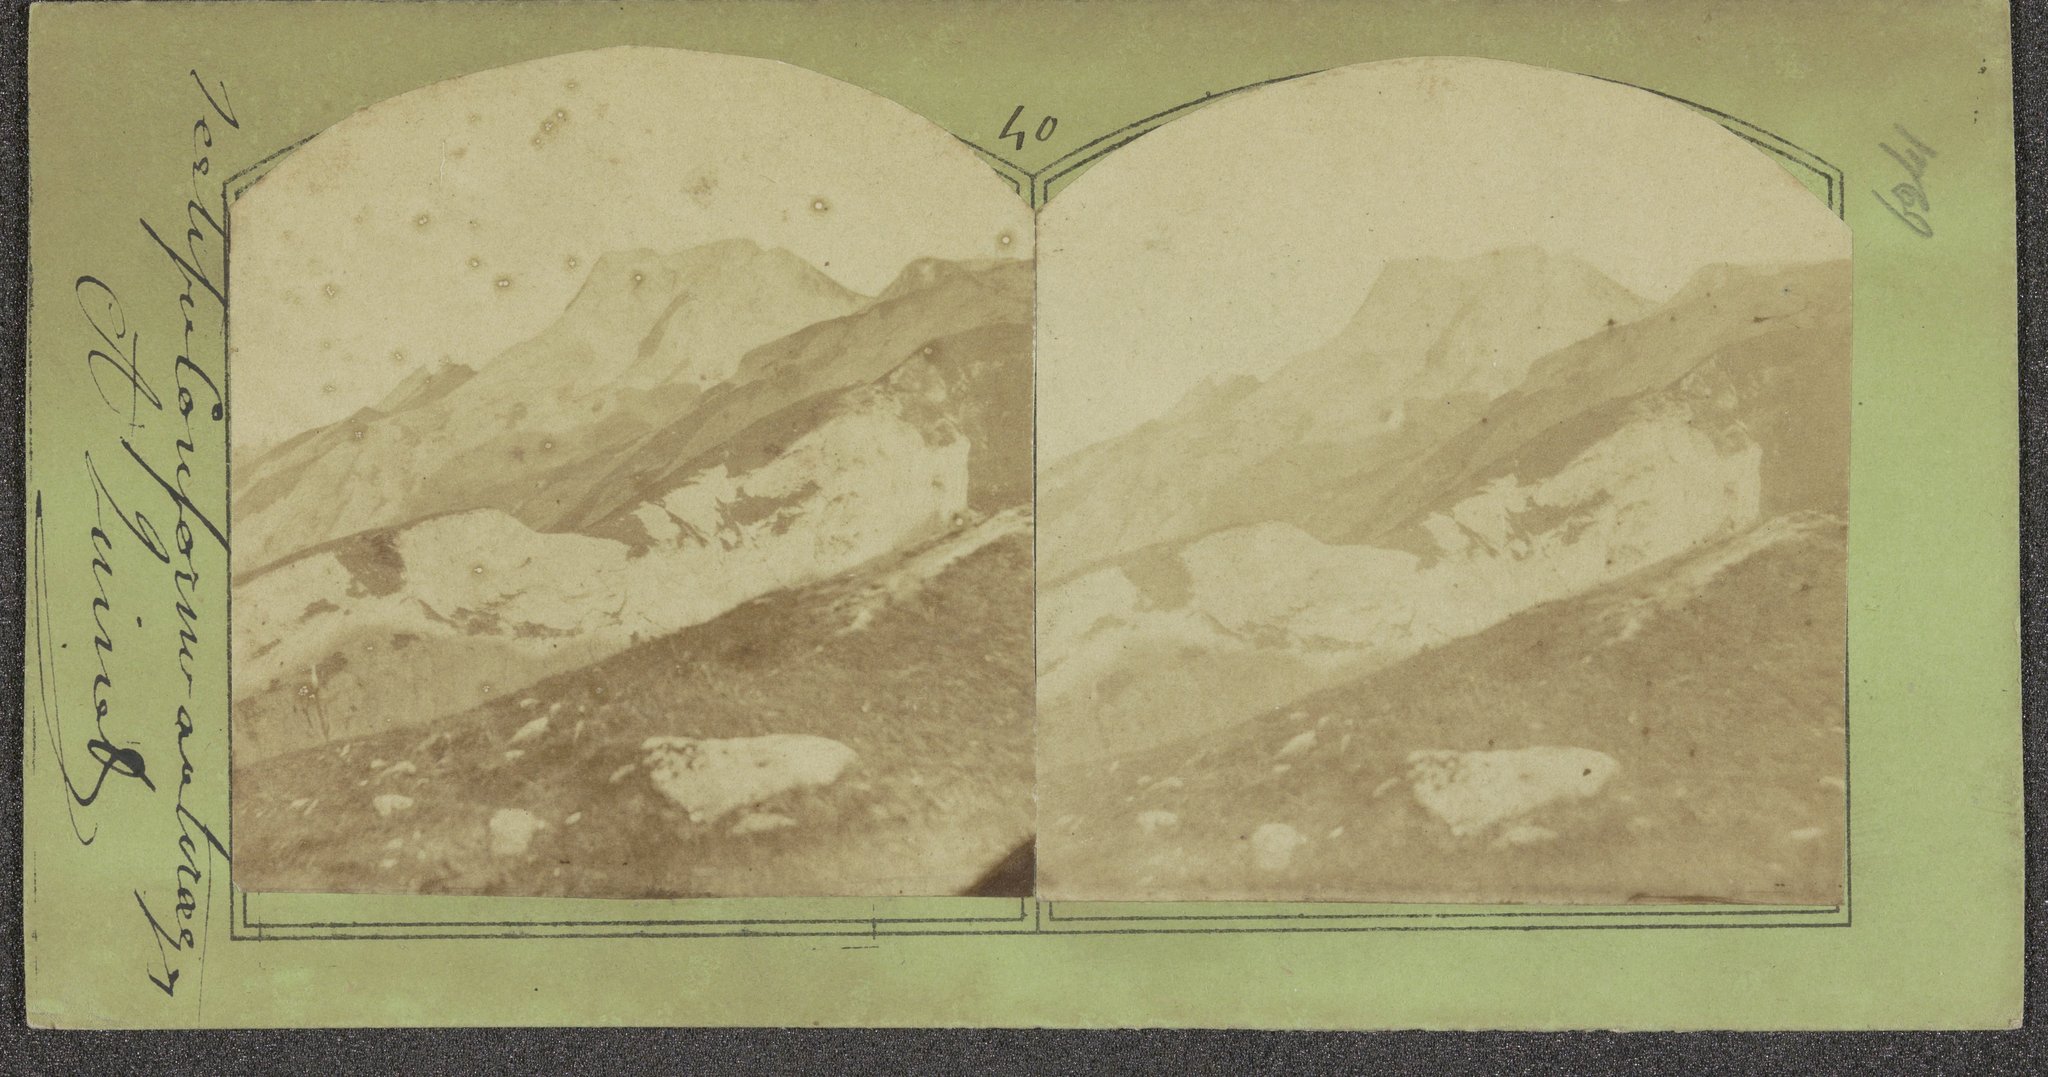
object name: stereograph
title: Berglandschap; de Alpen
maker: achille quinet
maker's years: 1831-1900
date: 1860-1880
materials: cardboard, paper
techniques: albumen print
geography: alps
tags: mountains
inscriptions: signature: ‘Sertifier conforme au tirages // A Quinet’